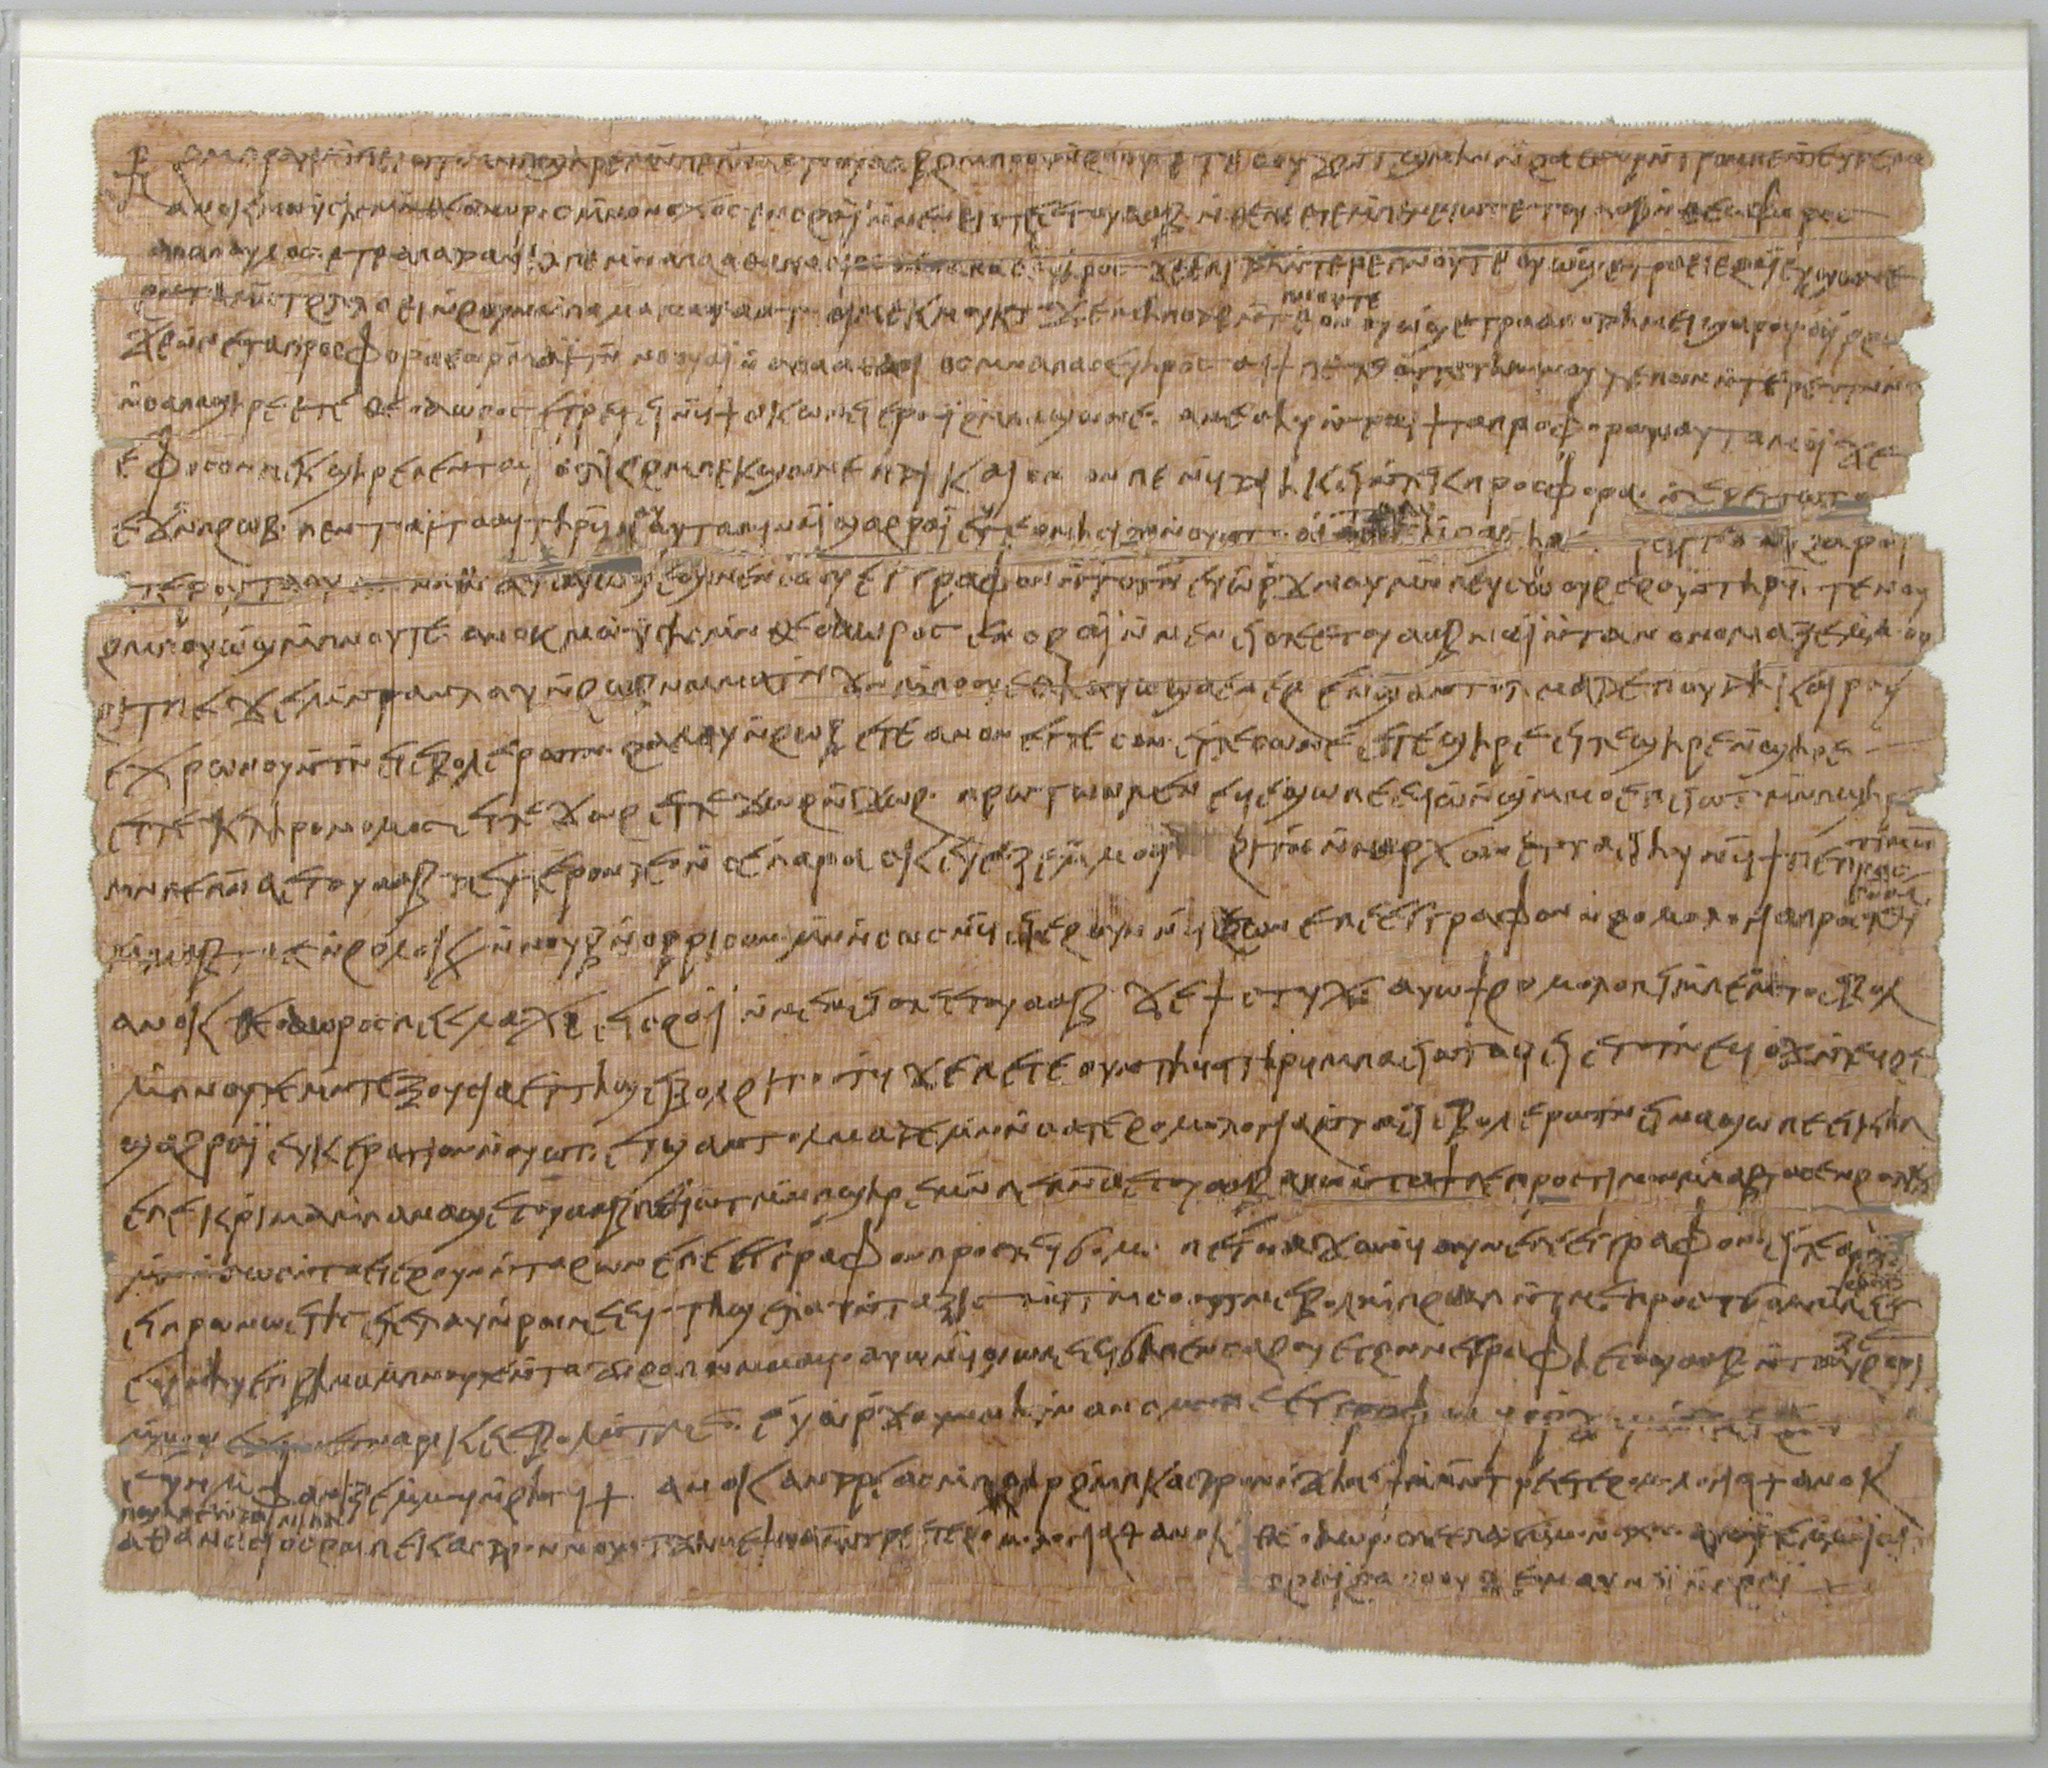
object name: papyrus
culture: coptic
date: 703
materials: ink, papyrus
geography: egypt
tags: coptic,documents